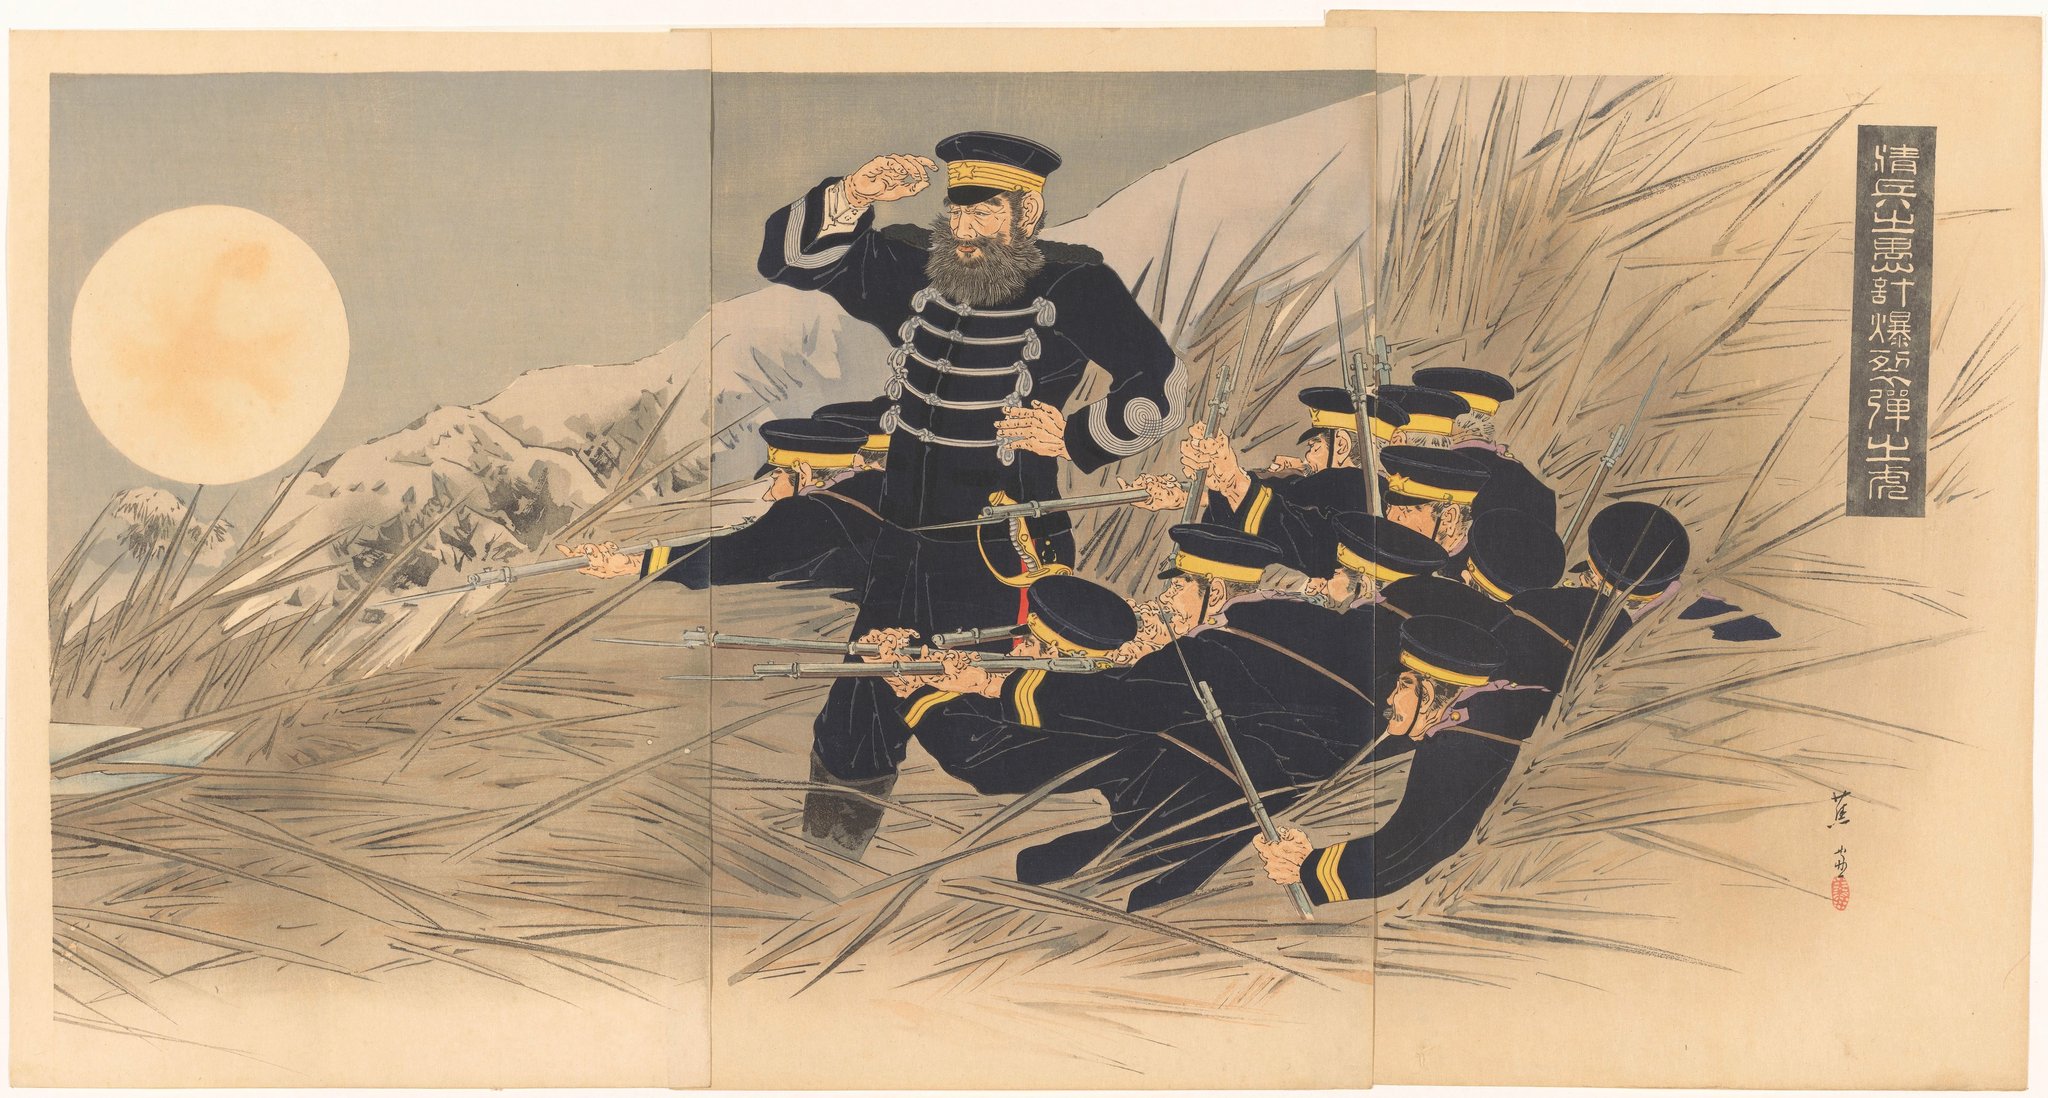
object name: print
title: Tijgers en soldaten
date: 1895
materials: paper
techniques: woodcut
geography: japan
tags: armour, warfare; military affairs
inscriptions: collector's mark: Lugt 2228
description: Groep Japanse soldaten tijdens de Sino-Japanse oorlog, tussen hoog gras, naar links gedraaid, bewapend met geweren en bajonetten. Bergachtig landschap en volle maan in achtergrond. Rechterdeel van zesluik (triptiek).